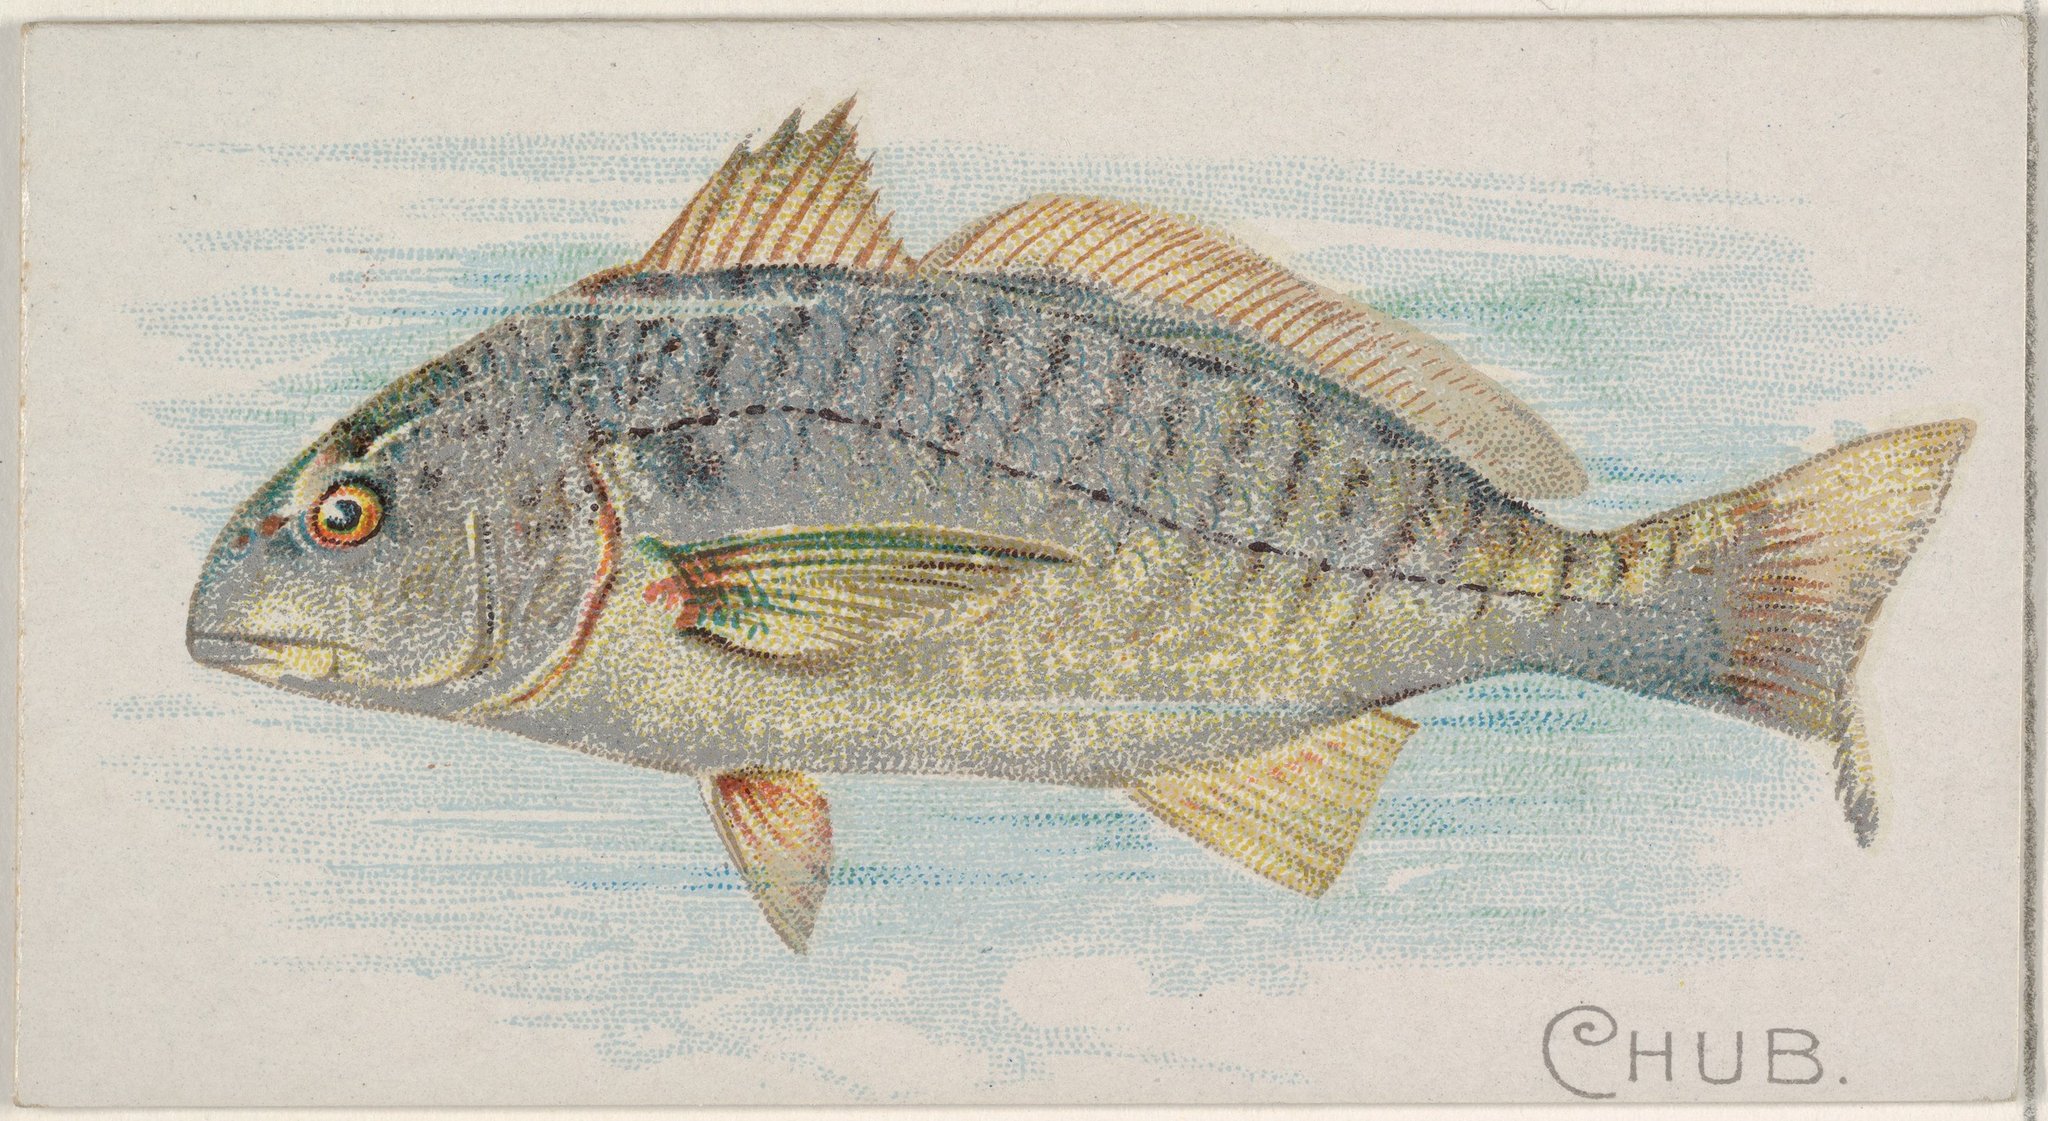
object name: print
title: Chub, from the Fish from American Waters series (N8) for Allen & Ginter Cigarettes Brands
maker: allen & ginter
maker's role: publisher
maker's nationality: american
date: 1889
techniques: color lithograph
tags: fish